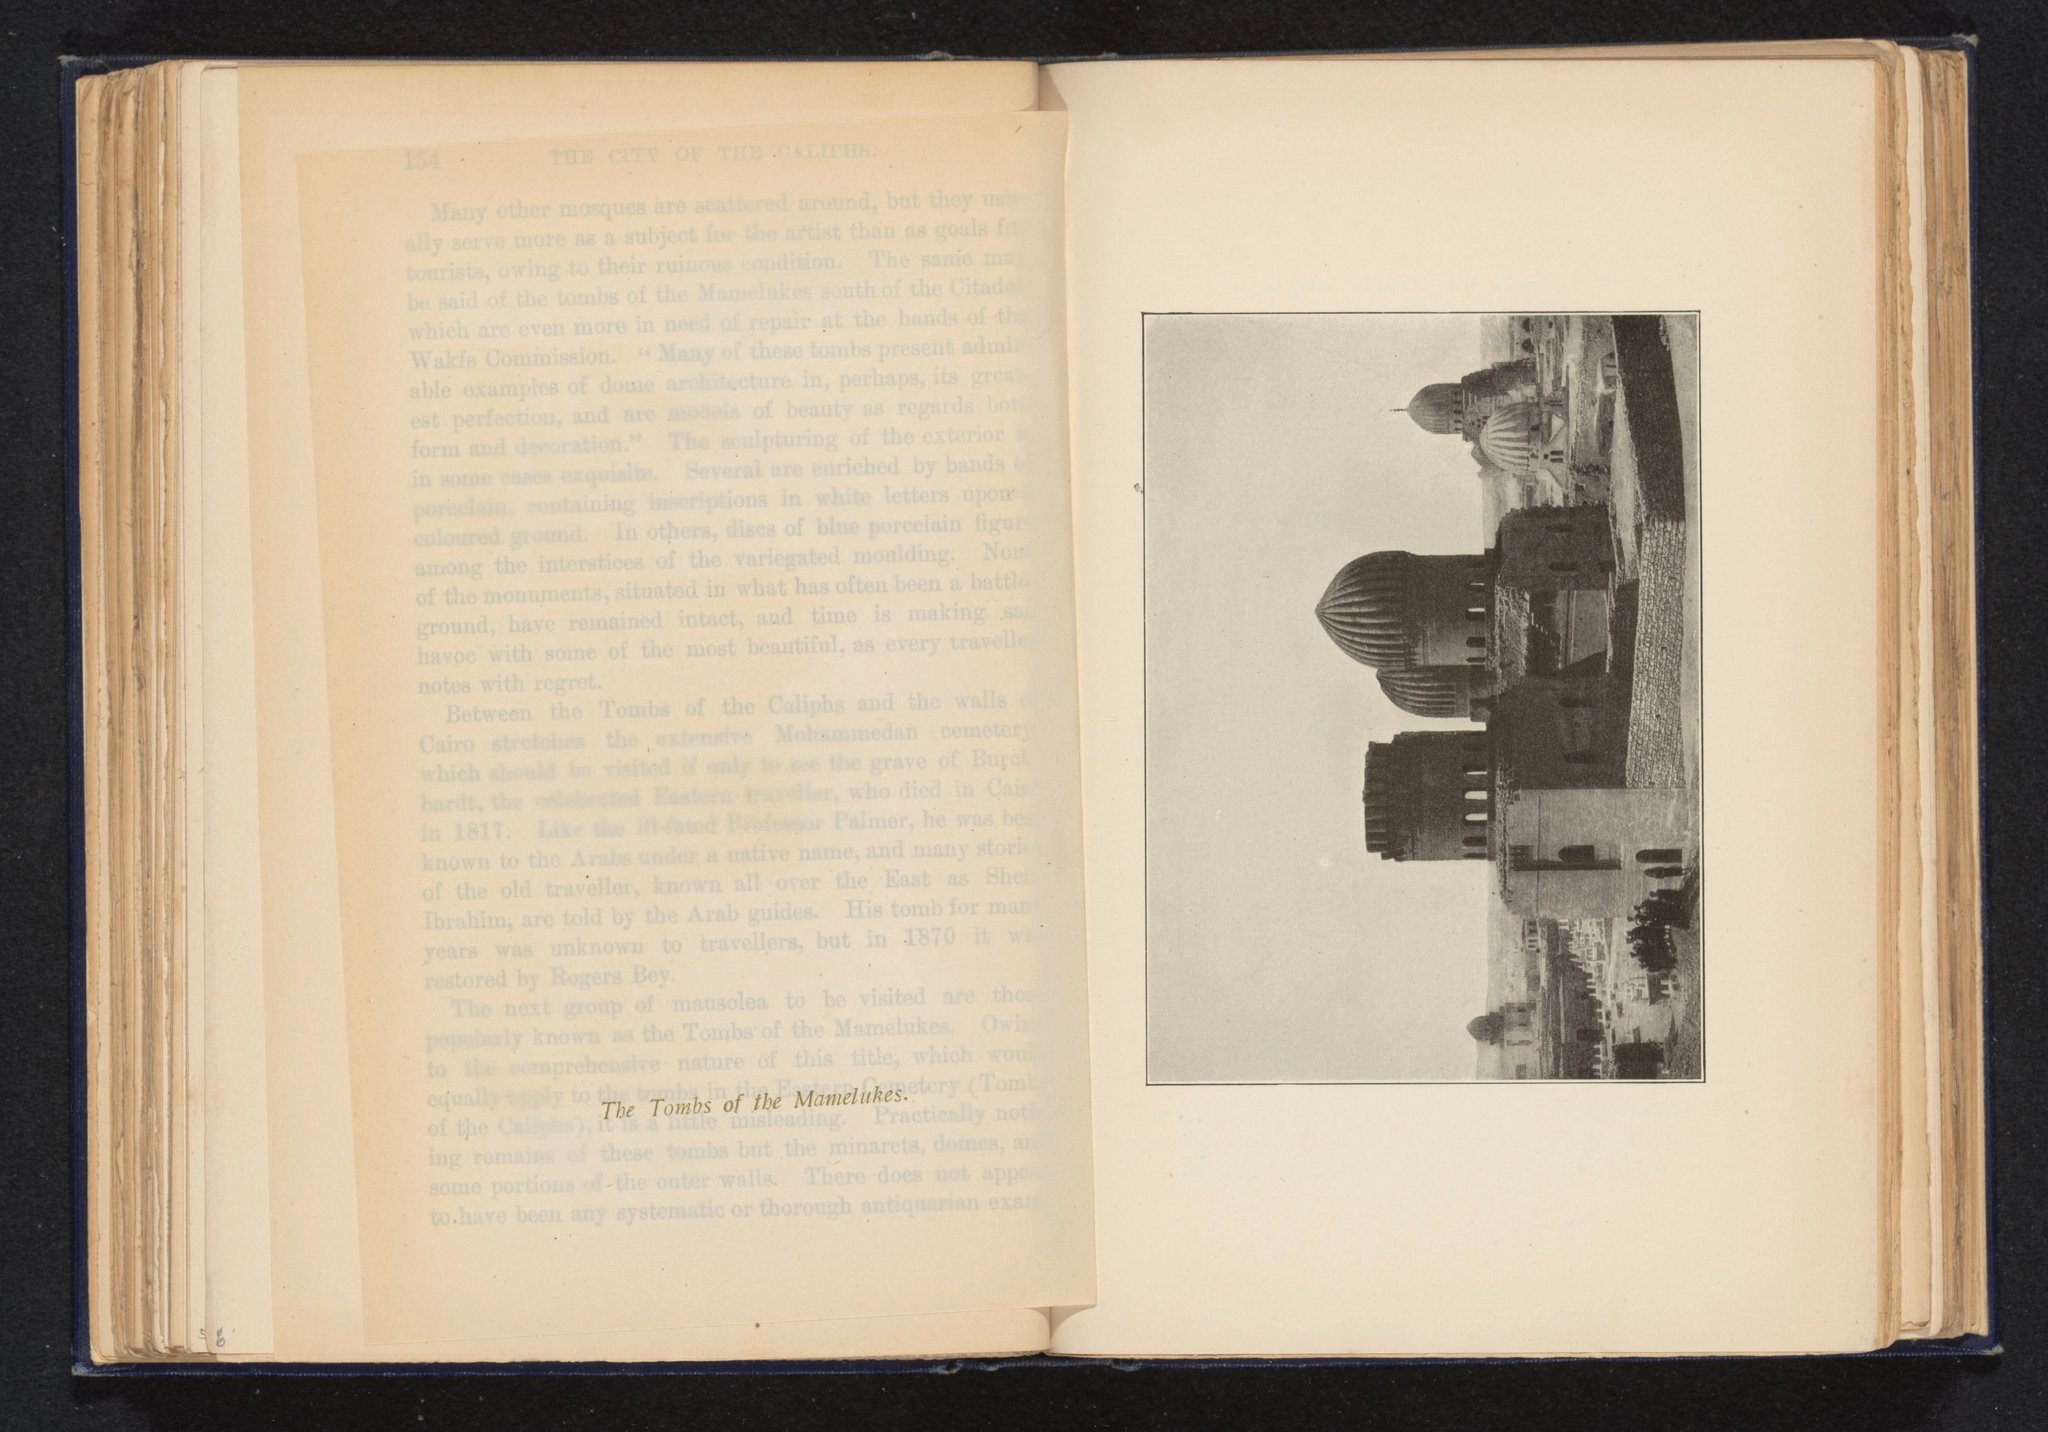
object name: photomechanical print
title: The Tombs of the Mamelukes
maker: Anonymous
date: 1891-1901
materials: paper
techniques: autotype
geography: cairo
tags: grave, tomb, slavery; serfs and enslaved persons